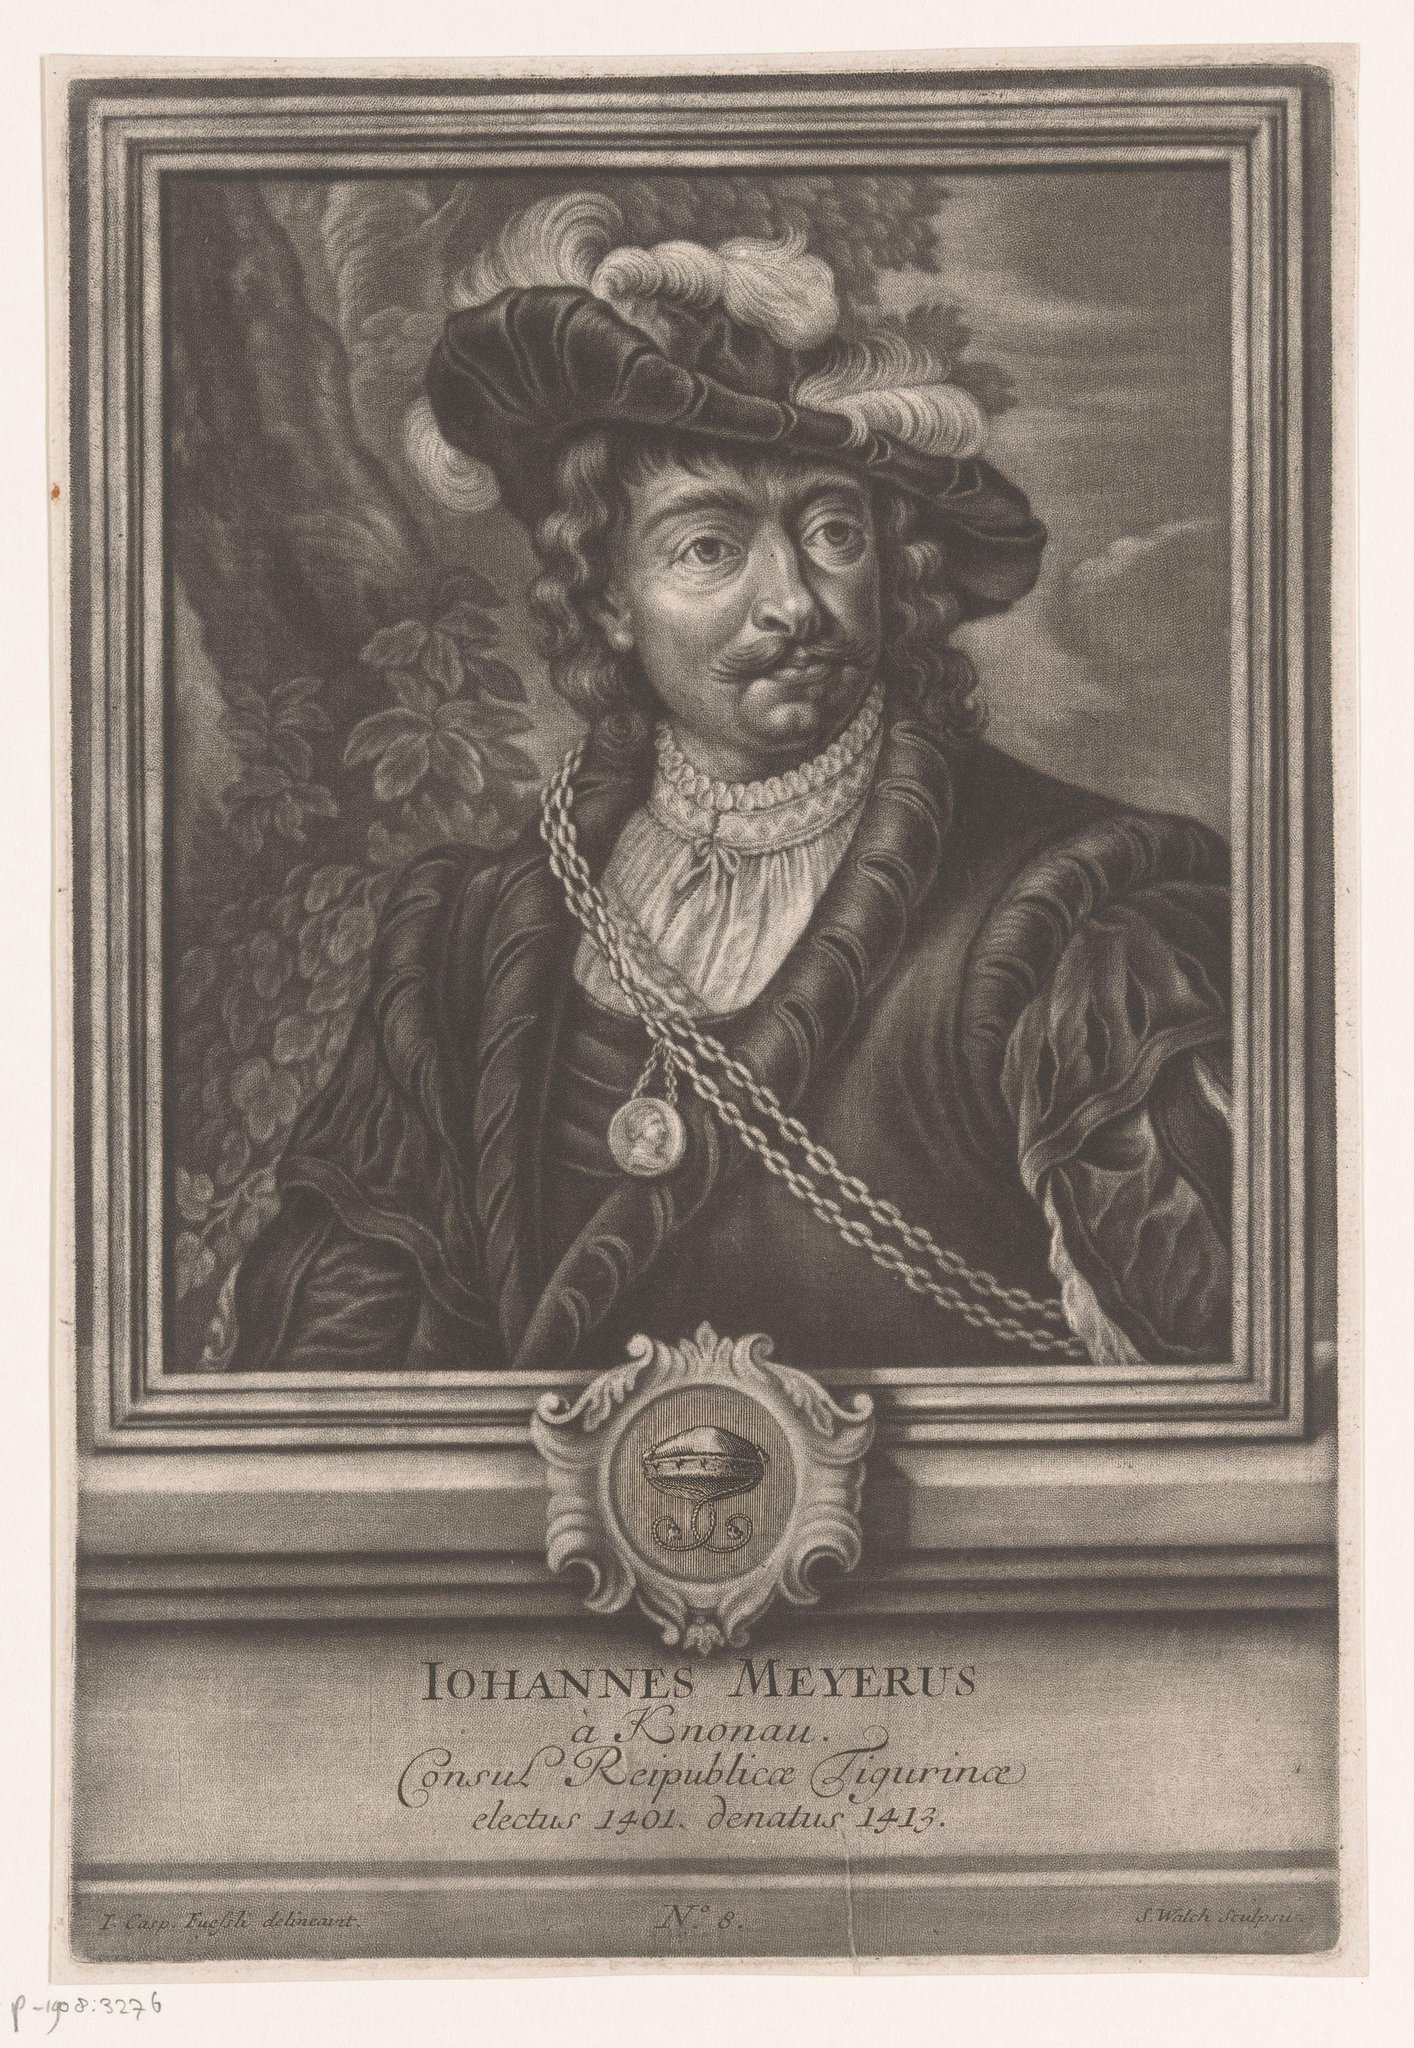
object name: print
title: Portret van Johannes Meyer von Kronau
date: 1731-1788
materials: paper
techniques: mezzotint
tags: politician, historical persons, armorial bearing, heraldry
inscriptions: collector's mark: Lugt 2228